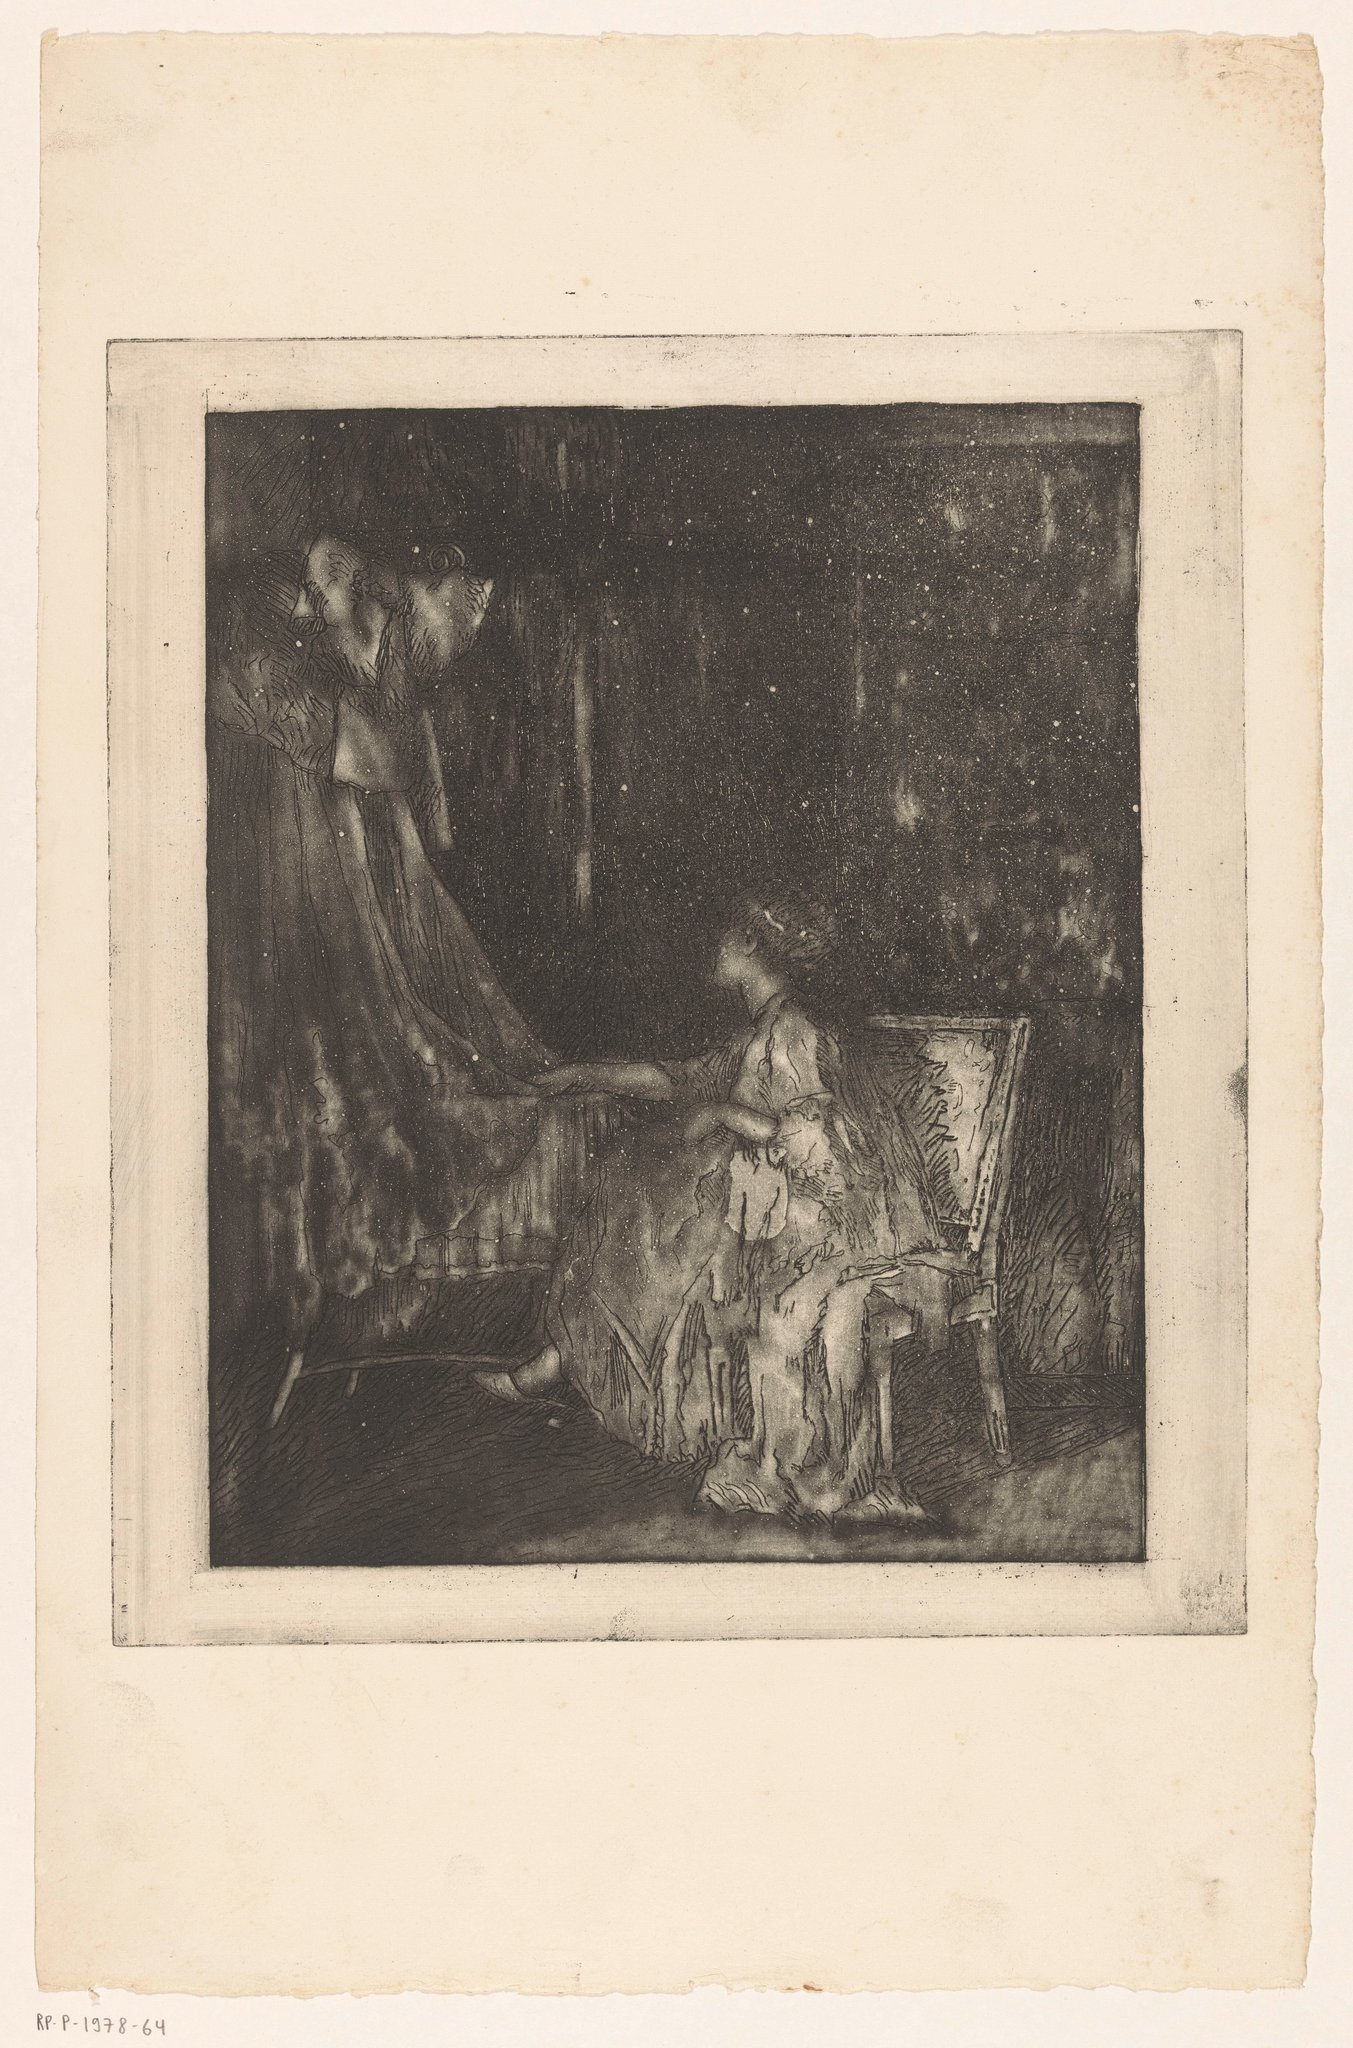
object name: print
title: Vrouw die op een stoel naast een wieg zit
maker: albert roelofs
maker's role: print maker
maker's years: 1877-1920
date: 1887-1920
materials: paper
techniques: aquatint, etching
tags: cradle, crib, mother and child(ren), woman and child(ren) (family group)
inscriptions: number: ‘1219 / 21’, collector's mark: Lugt 2760, collector's mark: Lugt 2228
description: De vrouw leunt met haar arm op de rand van de wieg.